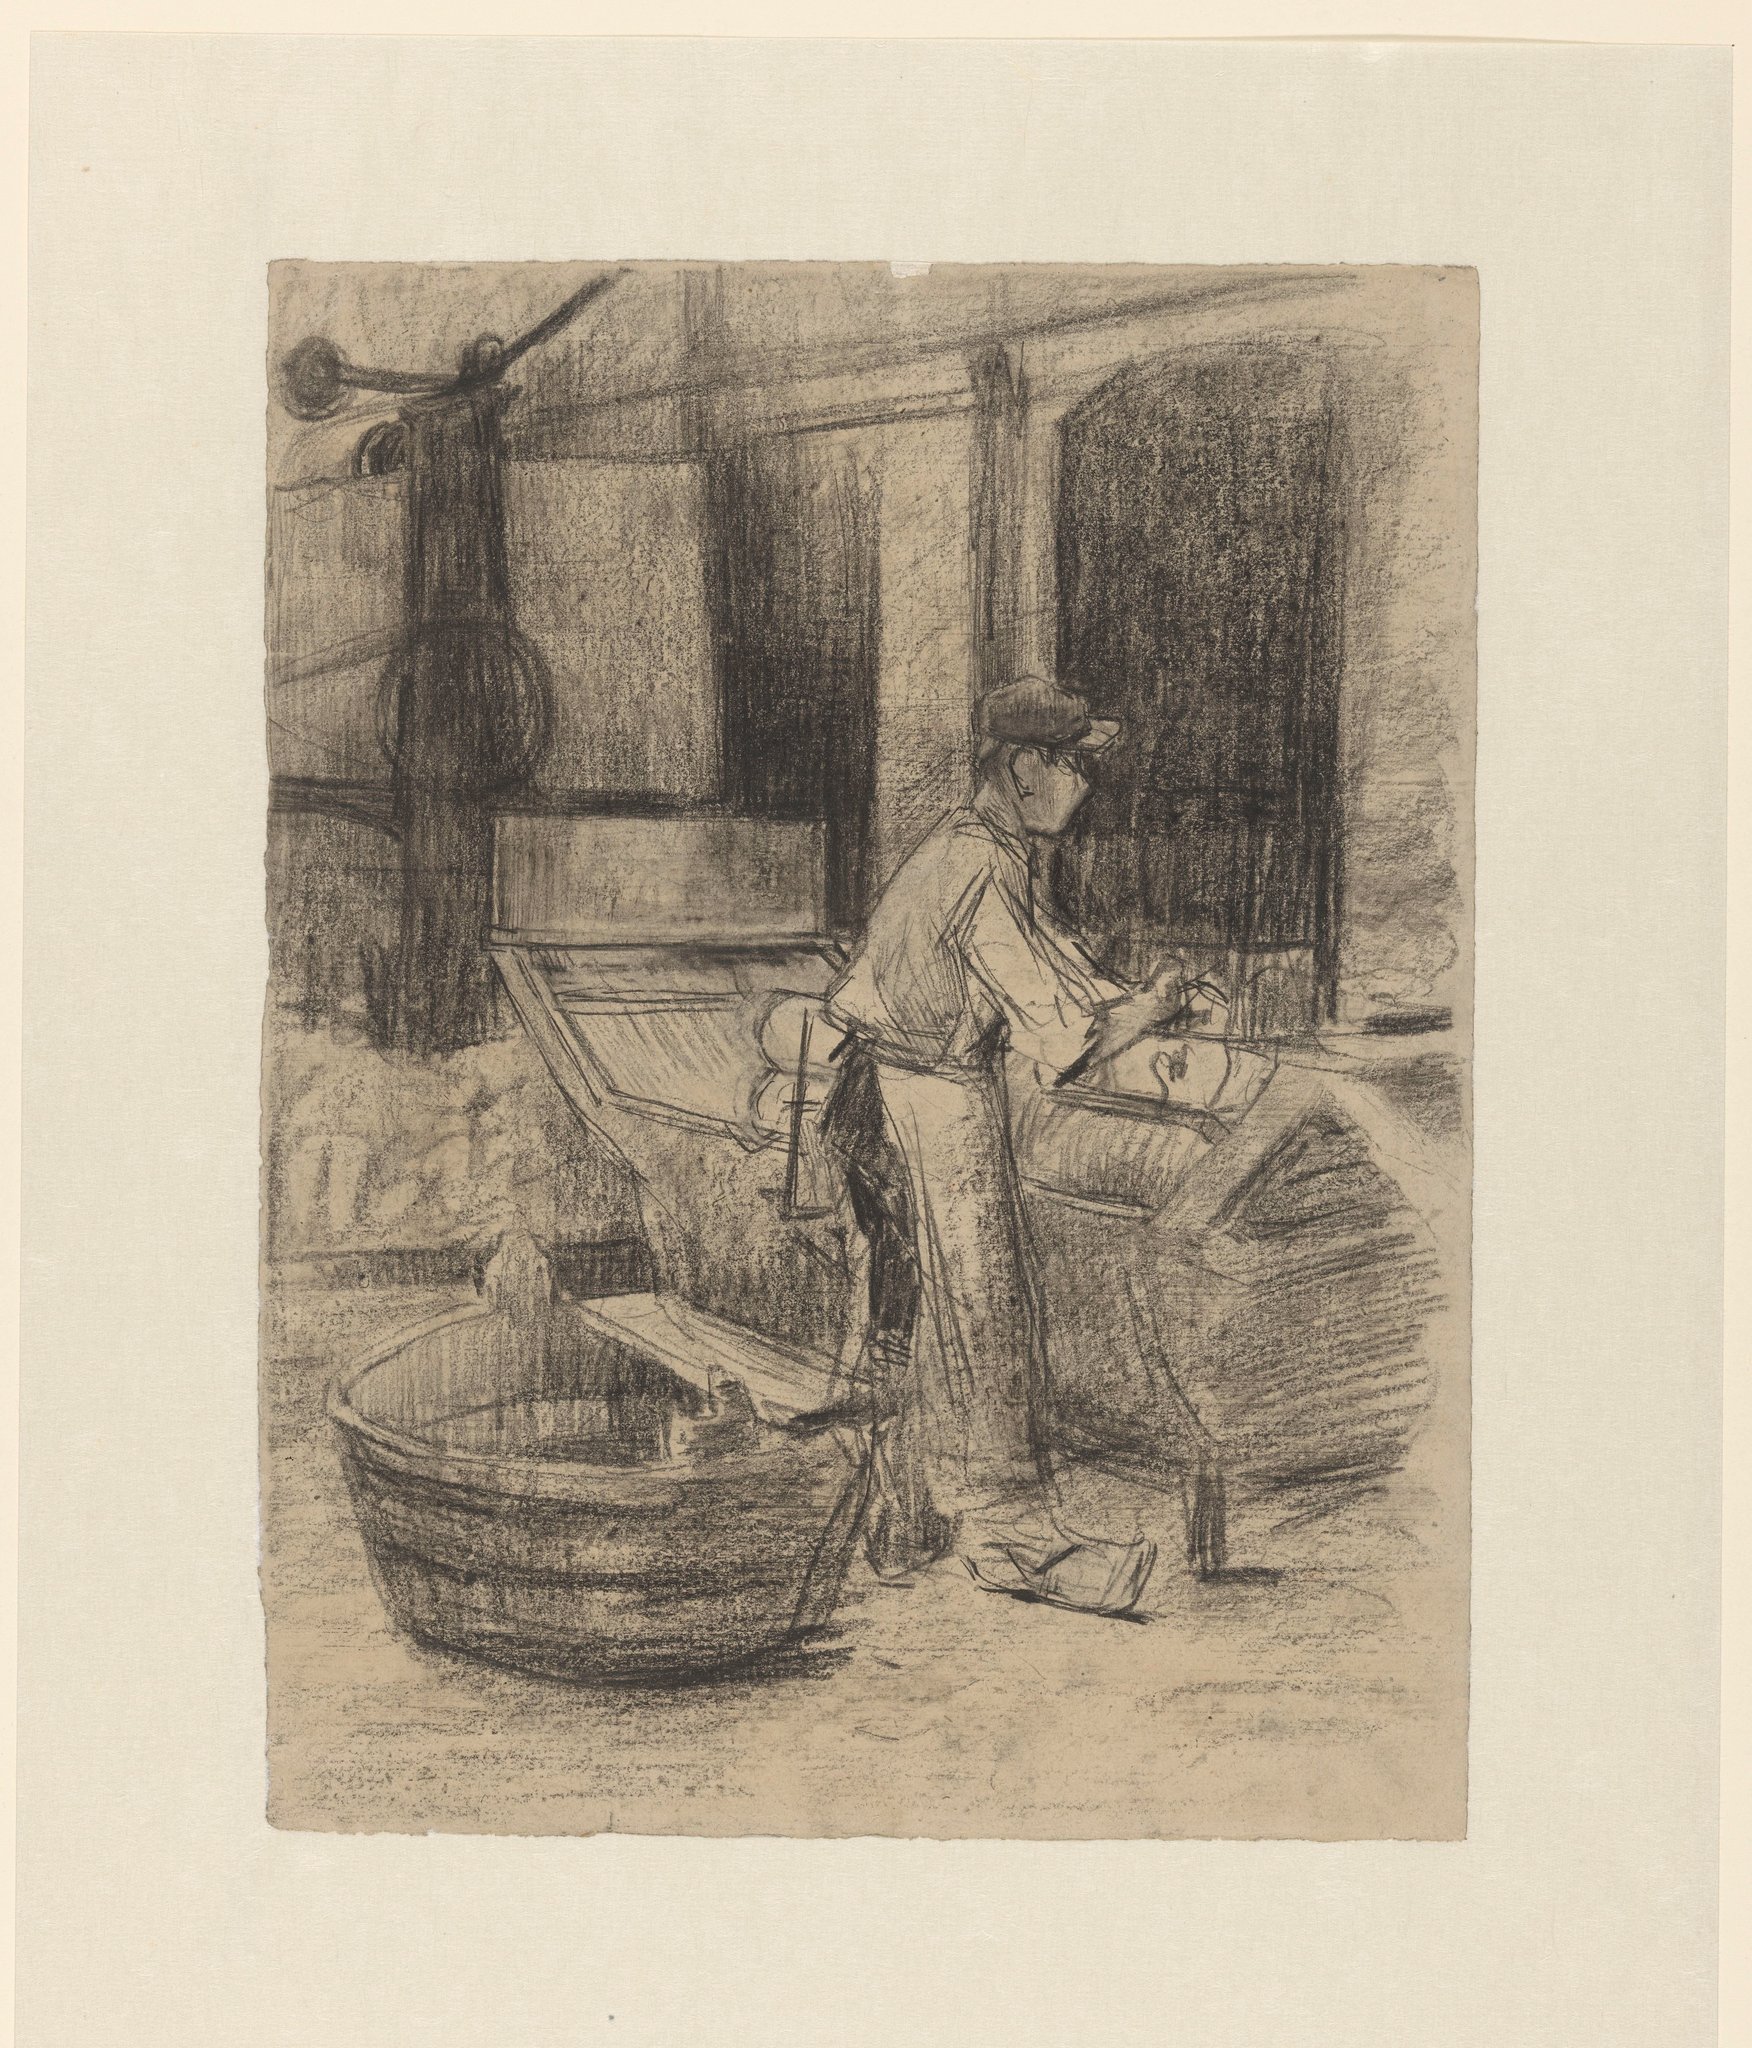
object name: drawing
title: In de katoenververij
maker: anthon gerhard alexander van rappard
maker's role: draughtsman, print maker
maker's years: 1858-1892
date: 1868-1892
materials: chalk, paper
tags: dyeing of cloth, cotton (material ~ textile industry)